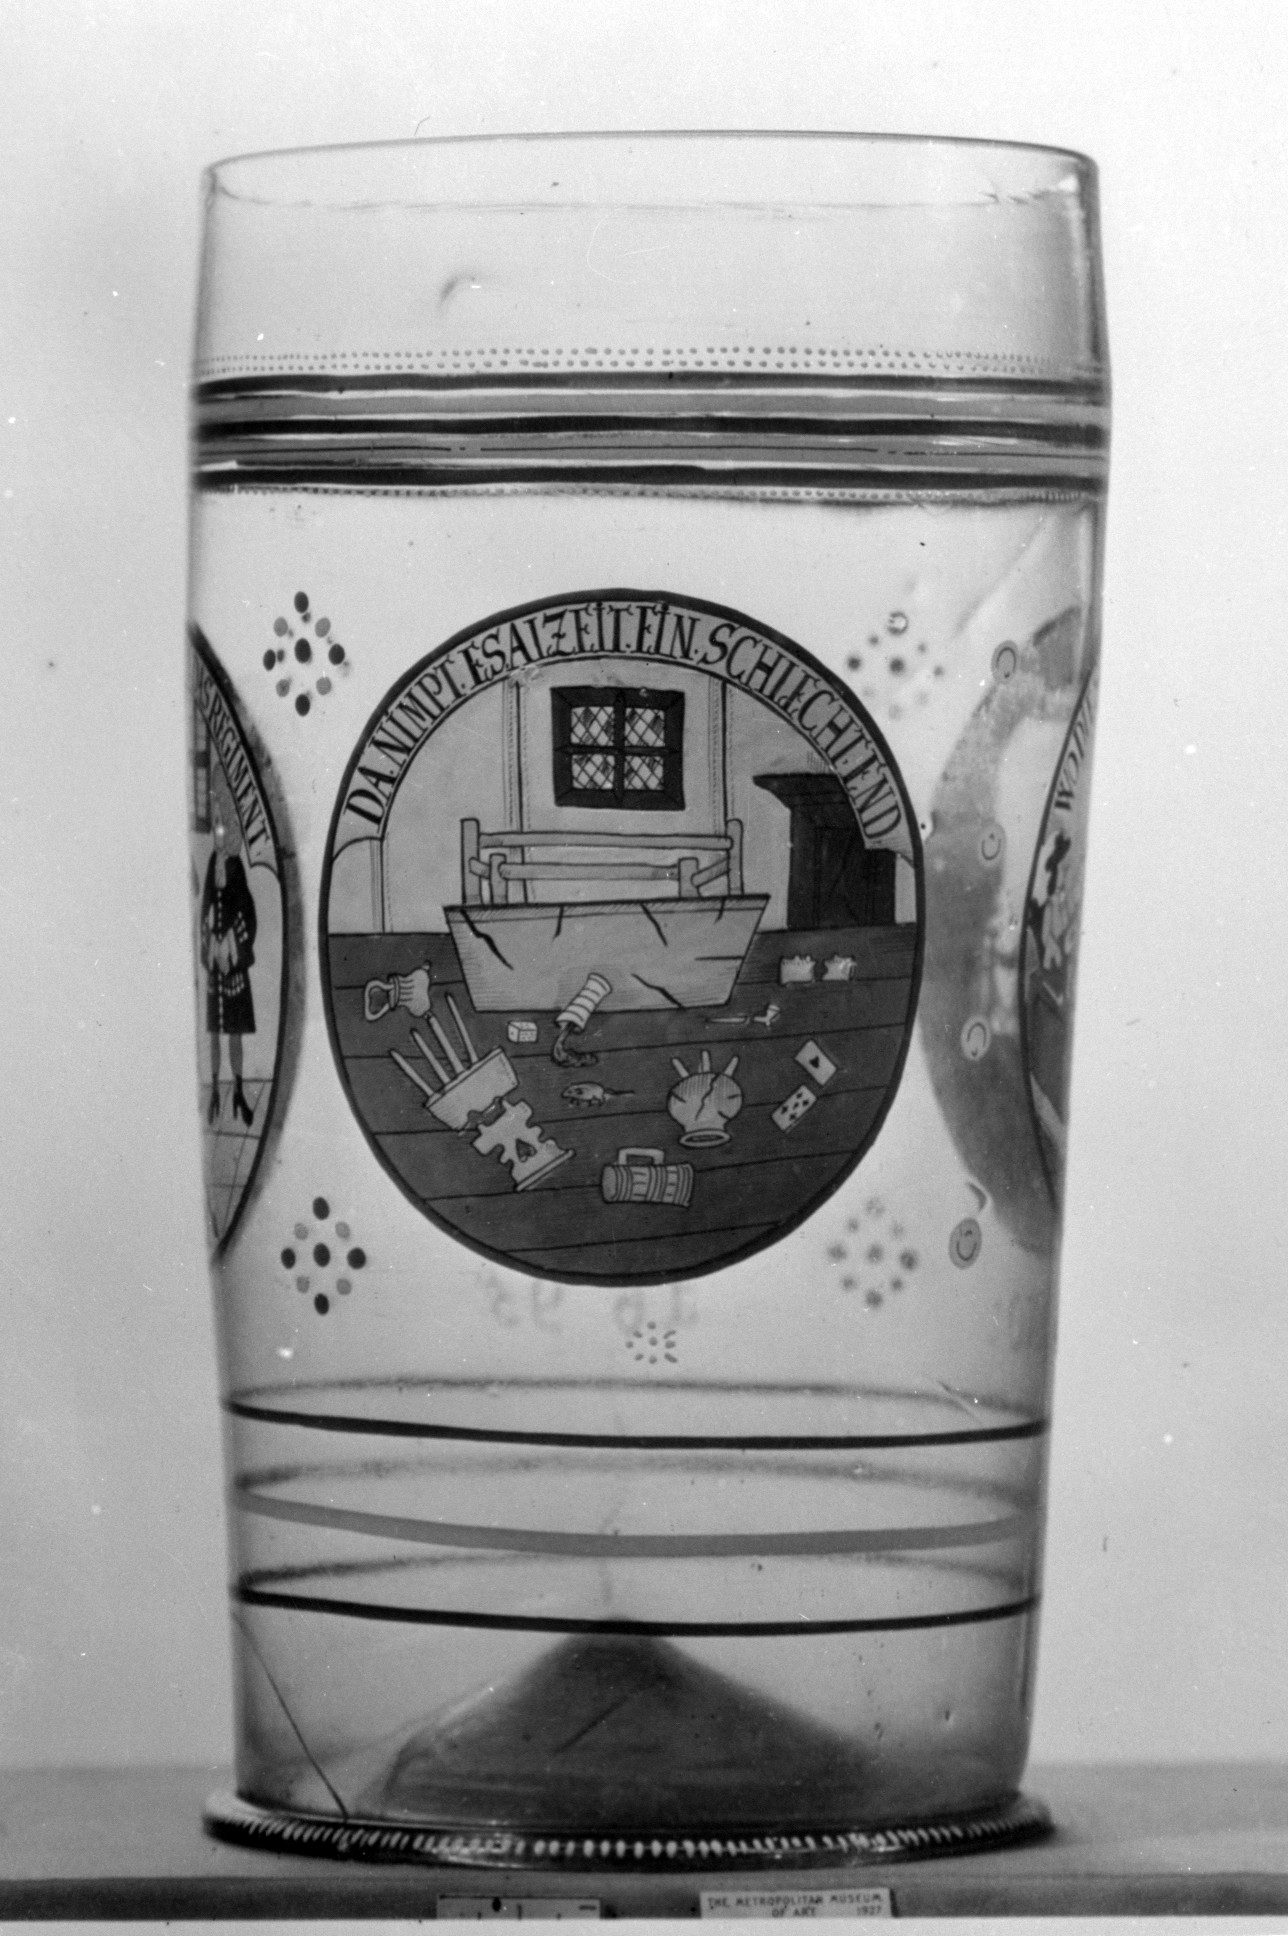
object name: beaker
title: Beaker (Humpen)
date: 1695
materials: glass